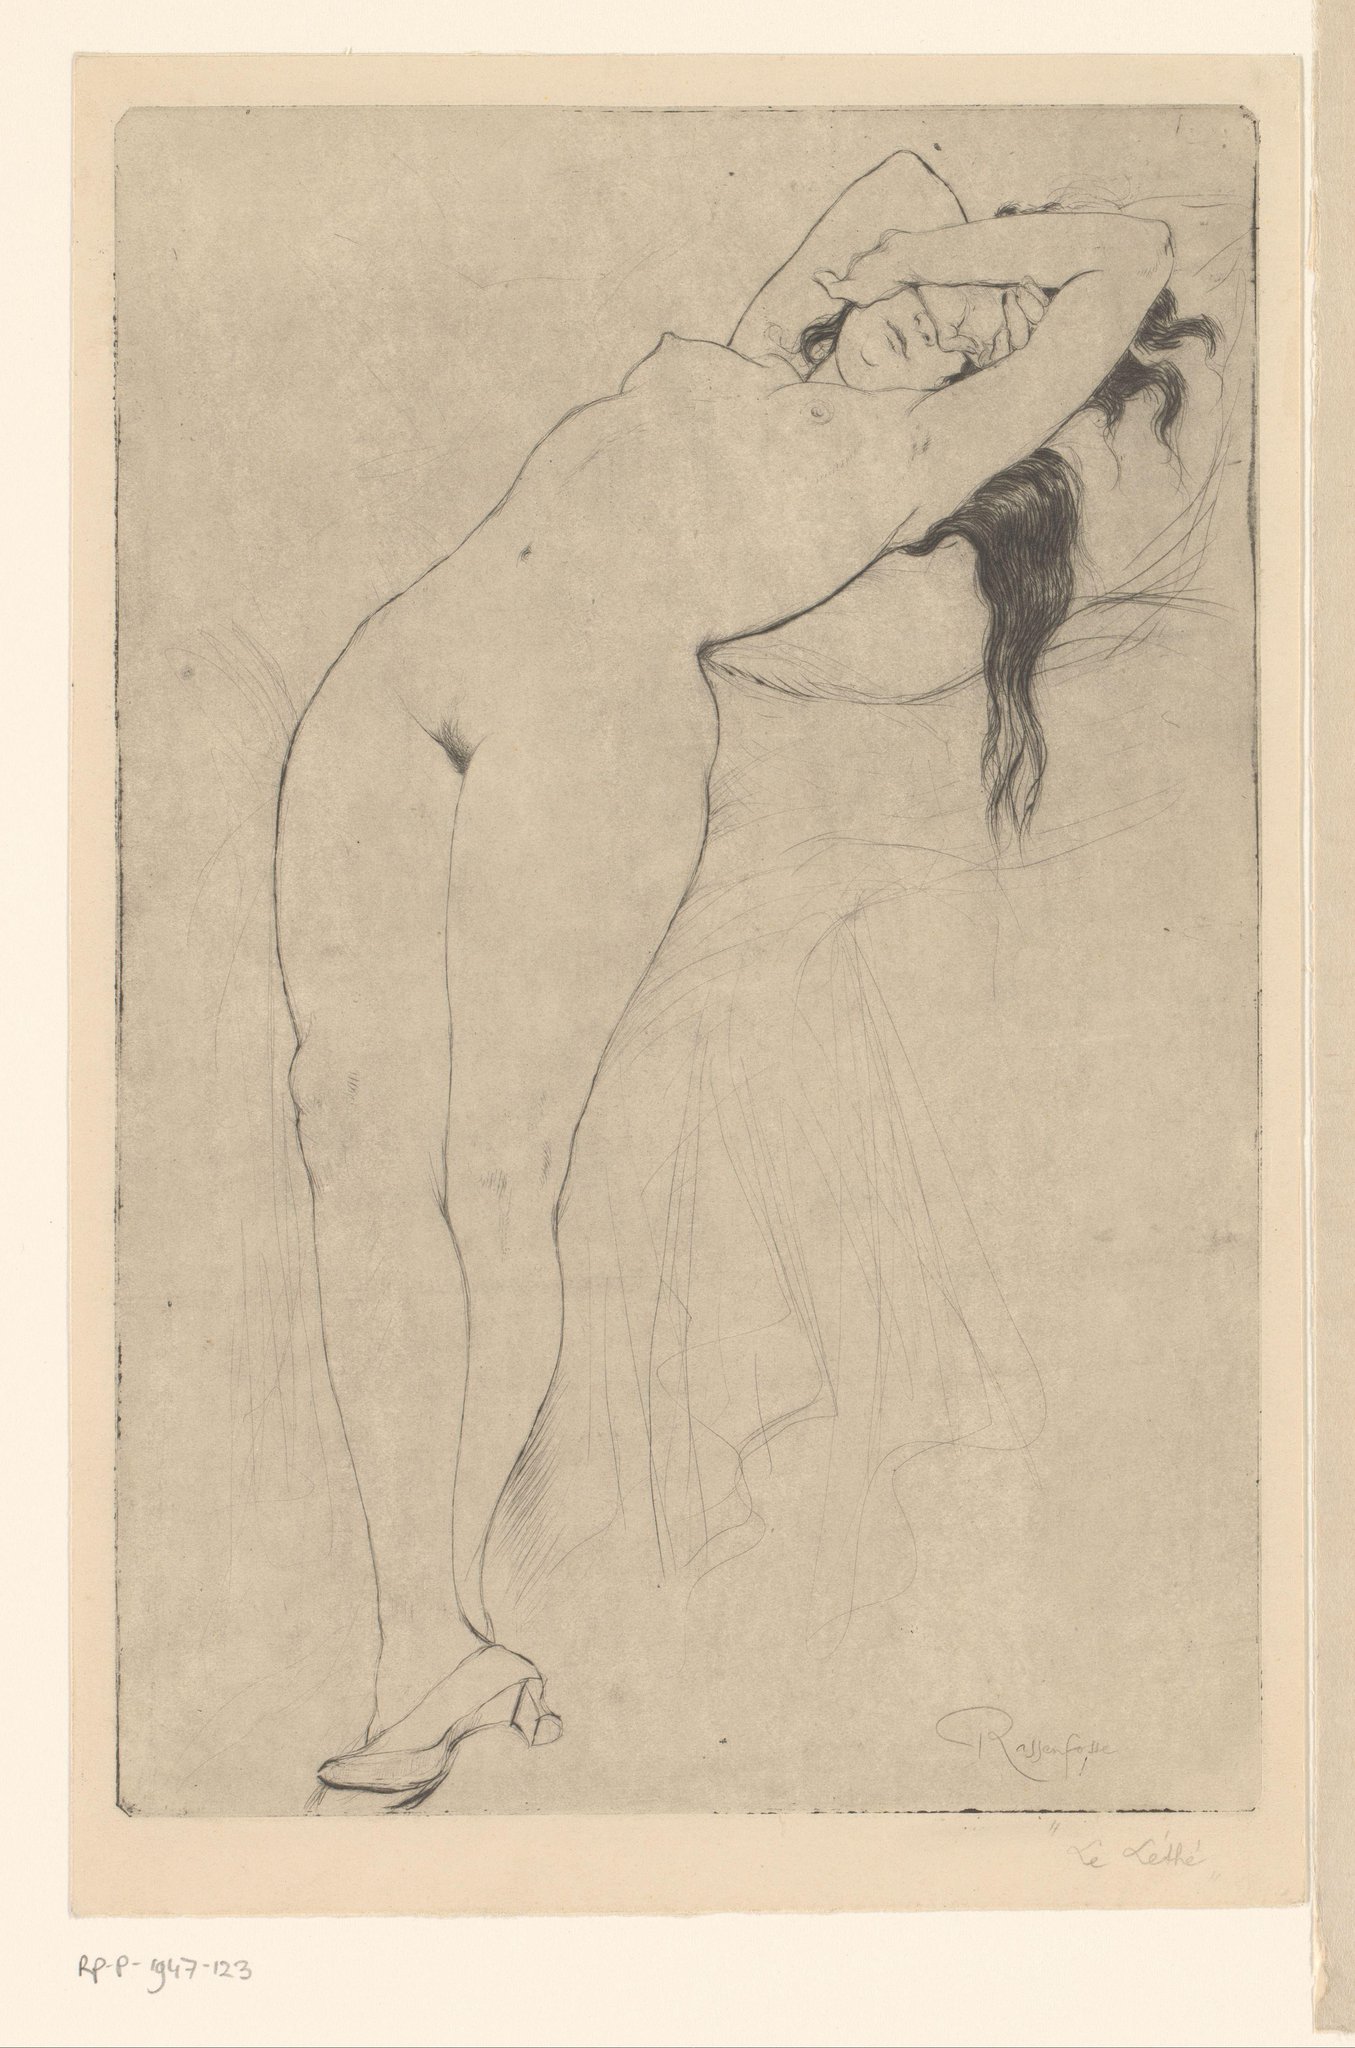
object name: print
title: Naakte vrouw met handen voor het gezicht en haar bovenlichaam rustend op een kussen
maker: armand rassenfosse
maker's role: draughtsman, painter, print maker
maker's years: 1862-1934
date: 1916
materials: paper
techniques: drypoint, etching, intaglio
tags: leaning backward - aa - female human figure, shoes, sandals, the (nude) human figure; 'corpo humano' (ripa) - aa - female human figure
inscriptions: collector's mark: Lugt 2760, collector's mark: Lugt 2228, inscription: ‘Le Léthé’